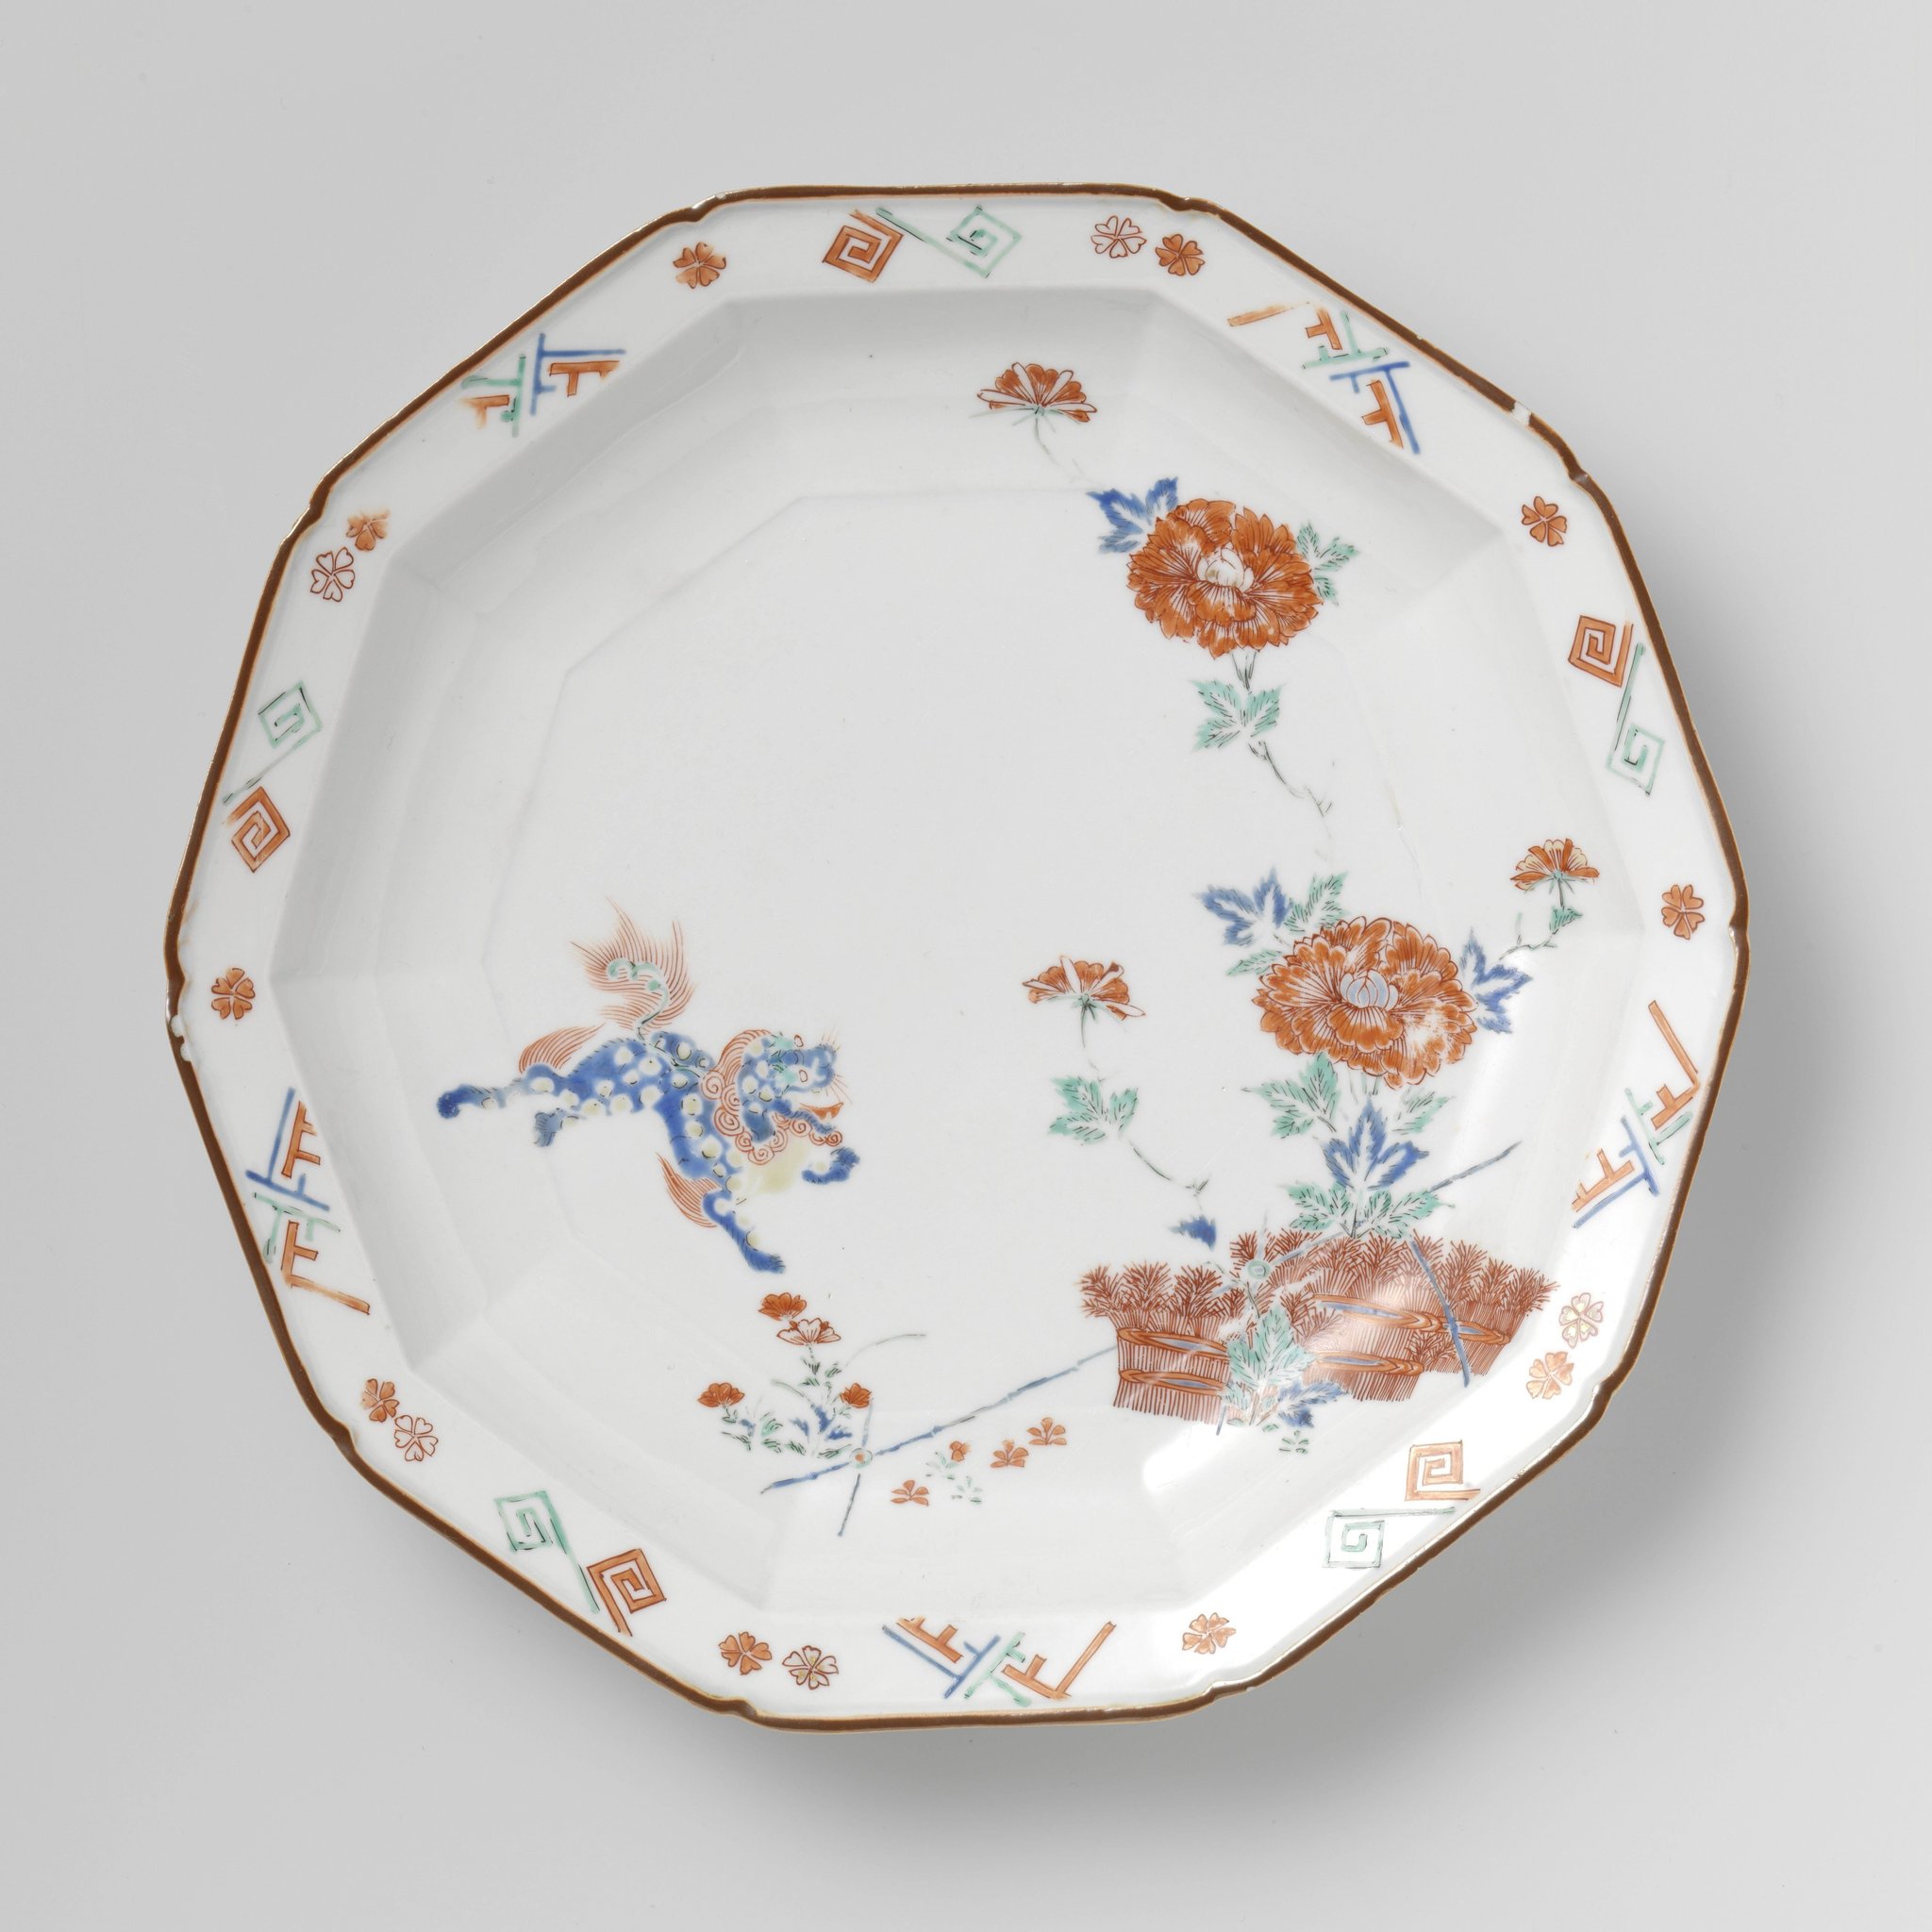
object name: plate dish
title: Decagonal dish with shishi and tree peony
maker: Anonymous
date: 1670-1690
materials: glaze, gold, paint, porcelain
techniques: firing, gilding, turning, vitrification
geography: arita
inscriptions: label: ‘Collectie Westendorp/ 7’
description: Plate. Kakiemon. Japan, Arita, c. 1700. Porcelain, decoration in underglaze blue and enamels. Westendorp bequest.